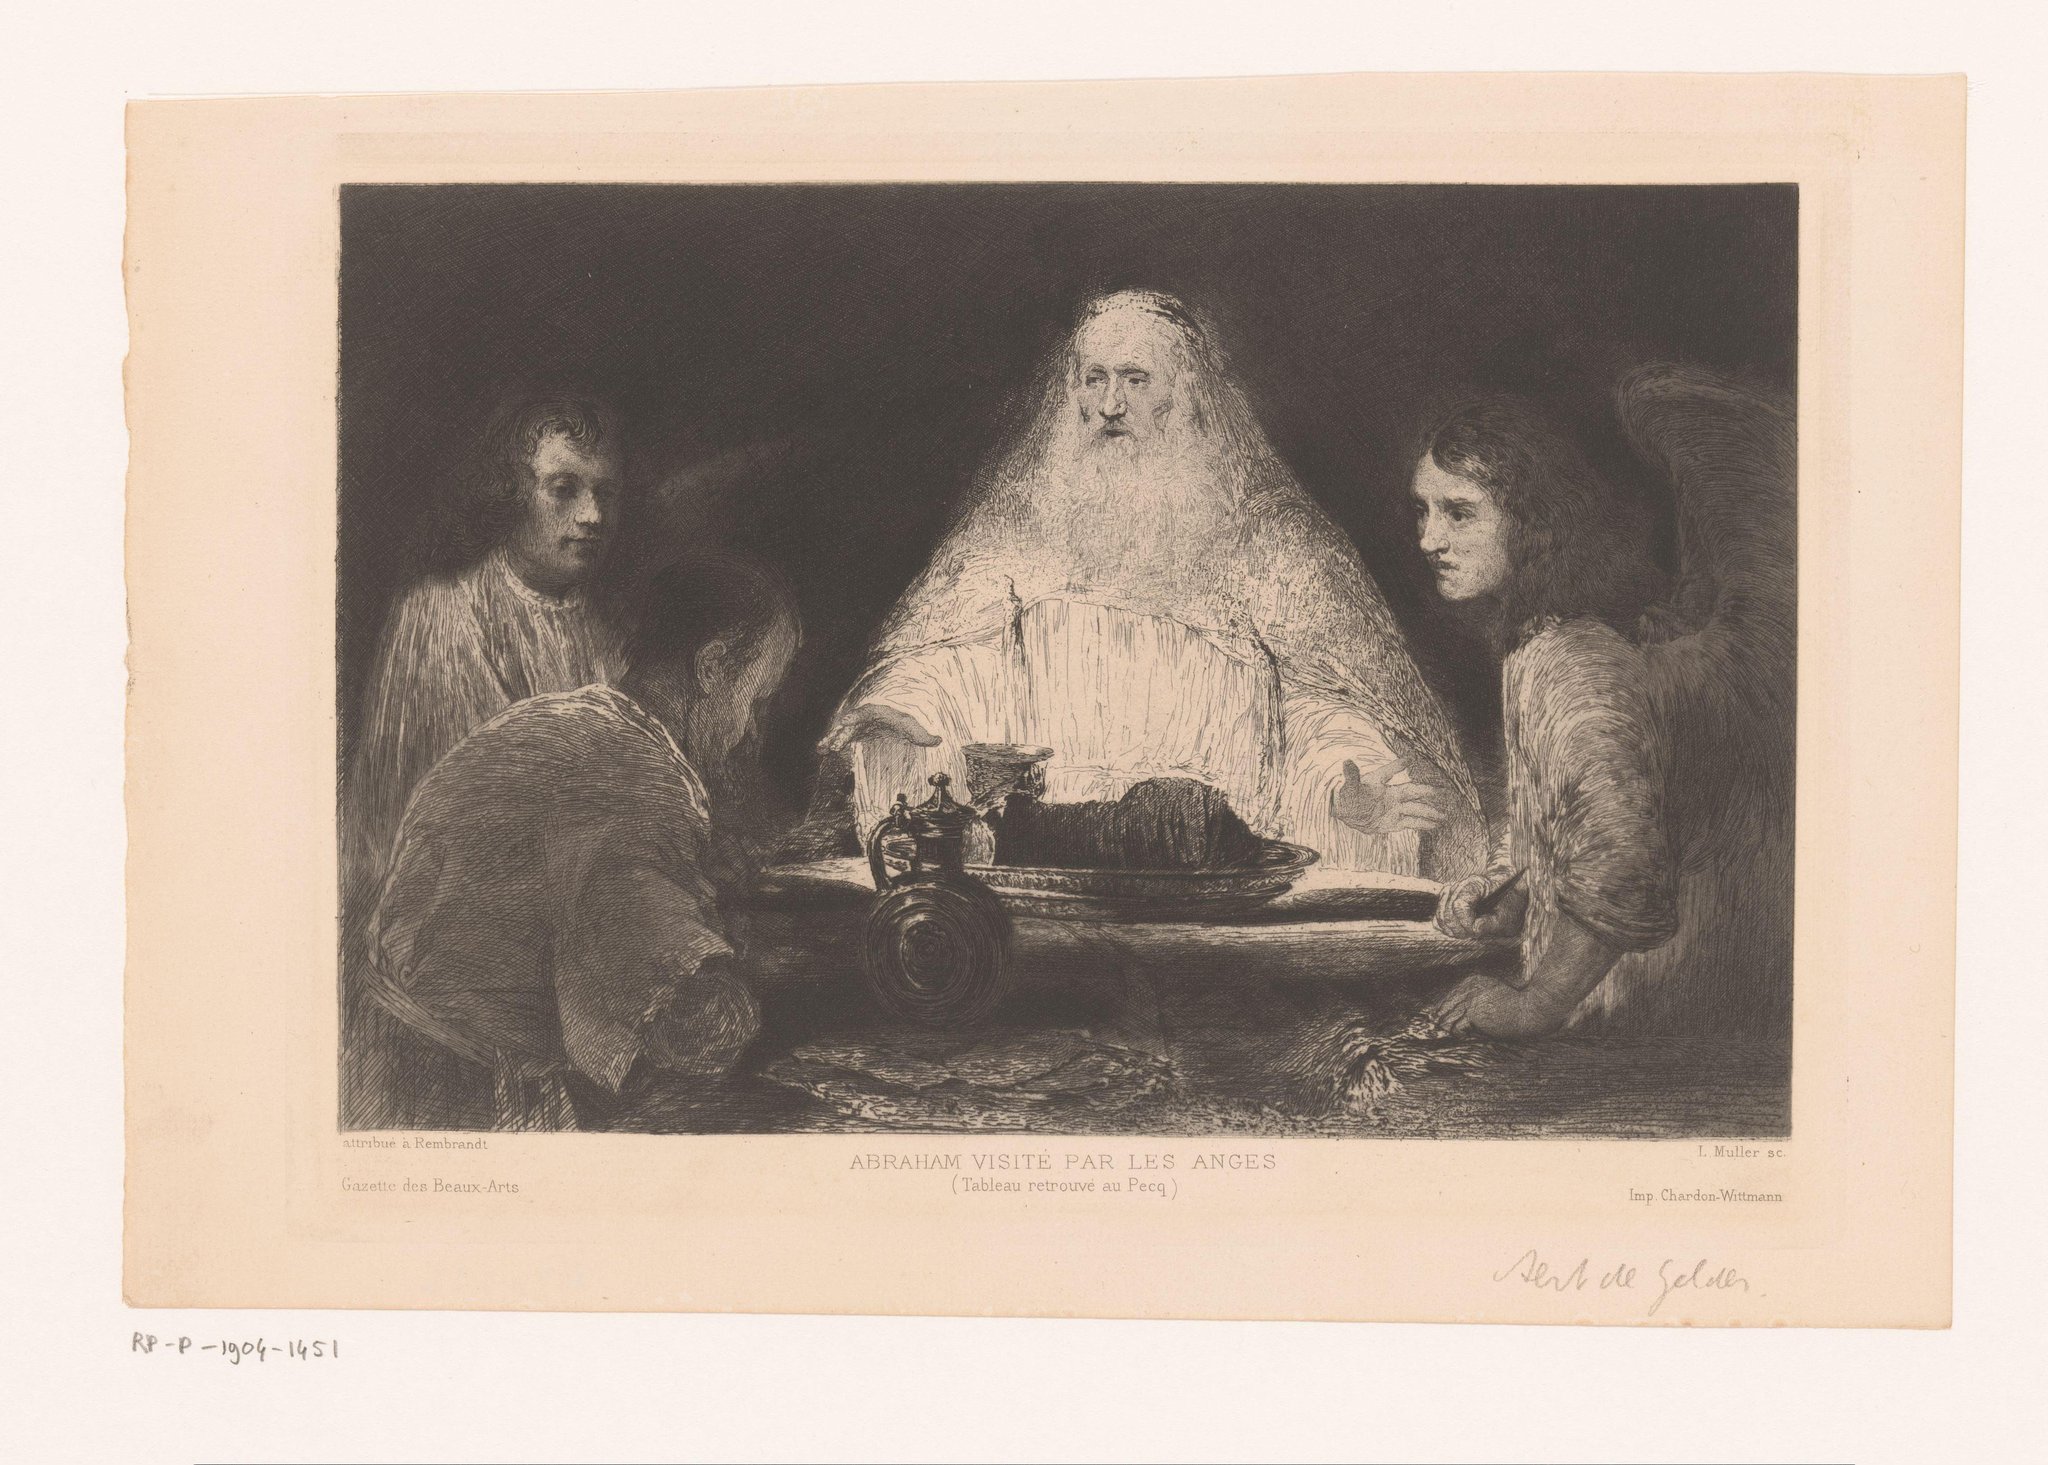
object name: print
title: Abraham en de engelen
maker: louis jean muller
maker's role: print maker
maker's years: 1864-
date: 1890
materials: paper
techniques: etching, intaglio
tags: abraham entertaining the three angels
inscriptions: collector's mark: Lugt 2228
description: Het schilderij bevindt zich in de collectie van het Museum Boijmans van Beuningen te Rotterdam, inv.nr. 1229.